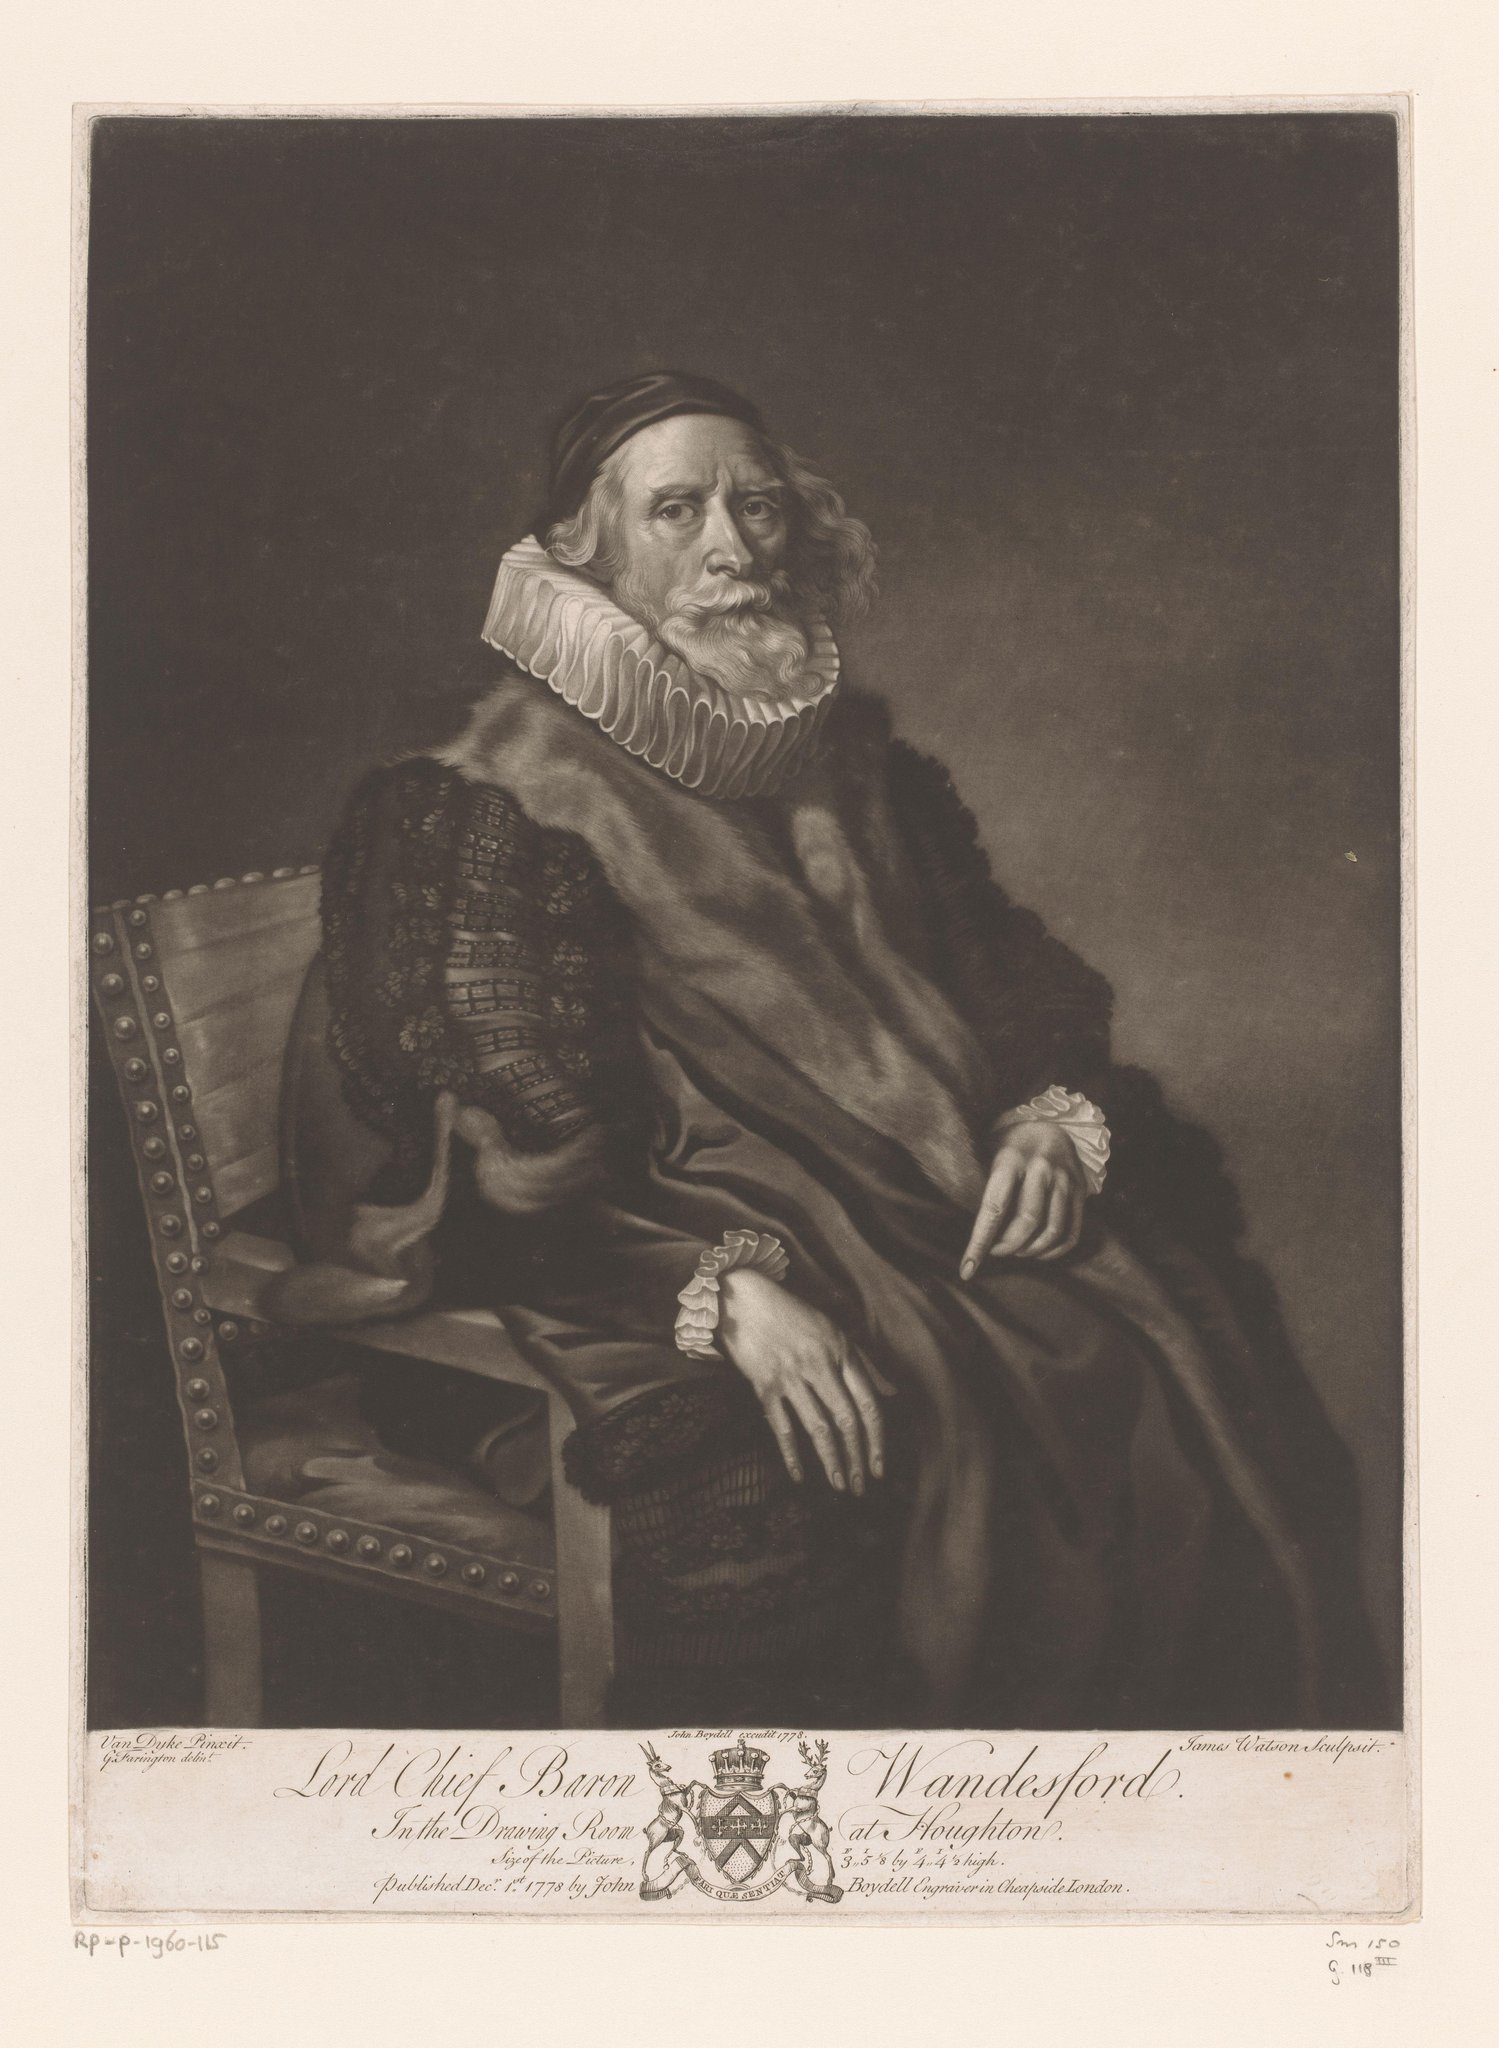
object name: print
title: Portret van Rowland Wandesford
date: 1712-1778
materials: paper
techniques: mezzotint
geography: london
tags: historical persons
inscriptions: collector's mark: Lugt 2760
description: Prent is onderdeel van een serie van 162 prenten naar schilderijen uit de collectie van Sir Robert Walpole in Houghton, op initiatief van uitgever John Boydell.